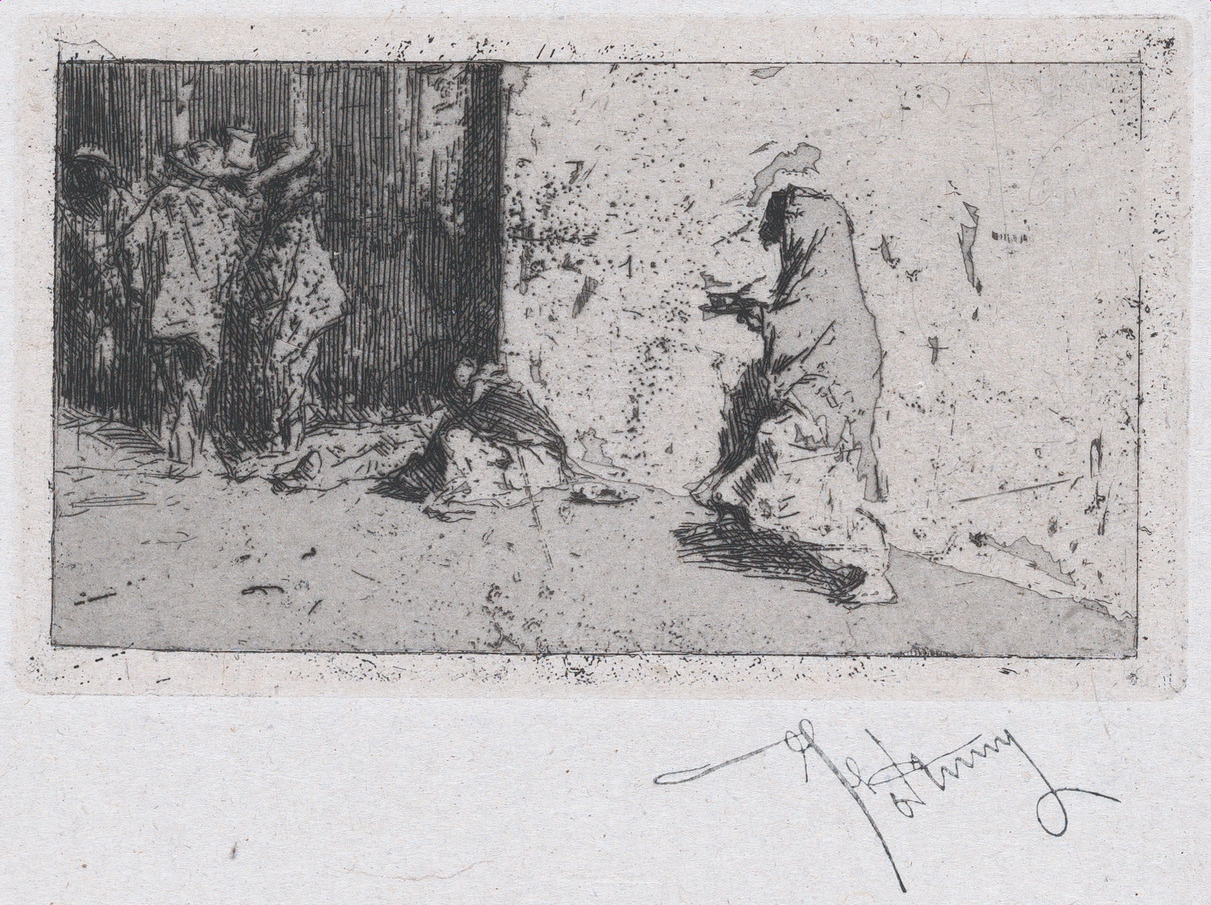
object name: print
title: A street in Seville with figures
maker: mariano fortuny, 1838–1874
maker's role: artist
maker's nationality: spanish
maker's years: 1838-1874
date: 1860-1870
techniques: etching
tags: human figures